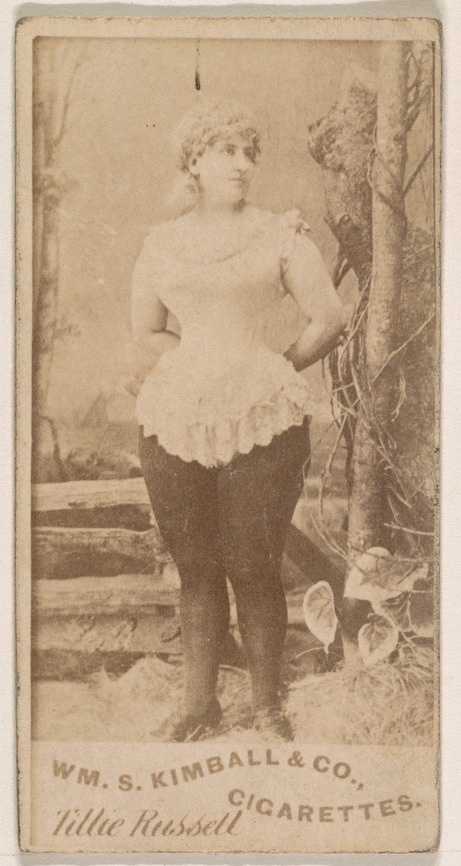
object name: photograph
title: Tillie Russell, from the Actresses series (N203) issued by Wm. S. Kimball & Co.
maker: william s. kimball & company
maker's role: publisher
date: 1889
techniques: color lithograph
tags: portraits,women,actresses